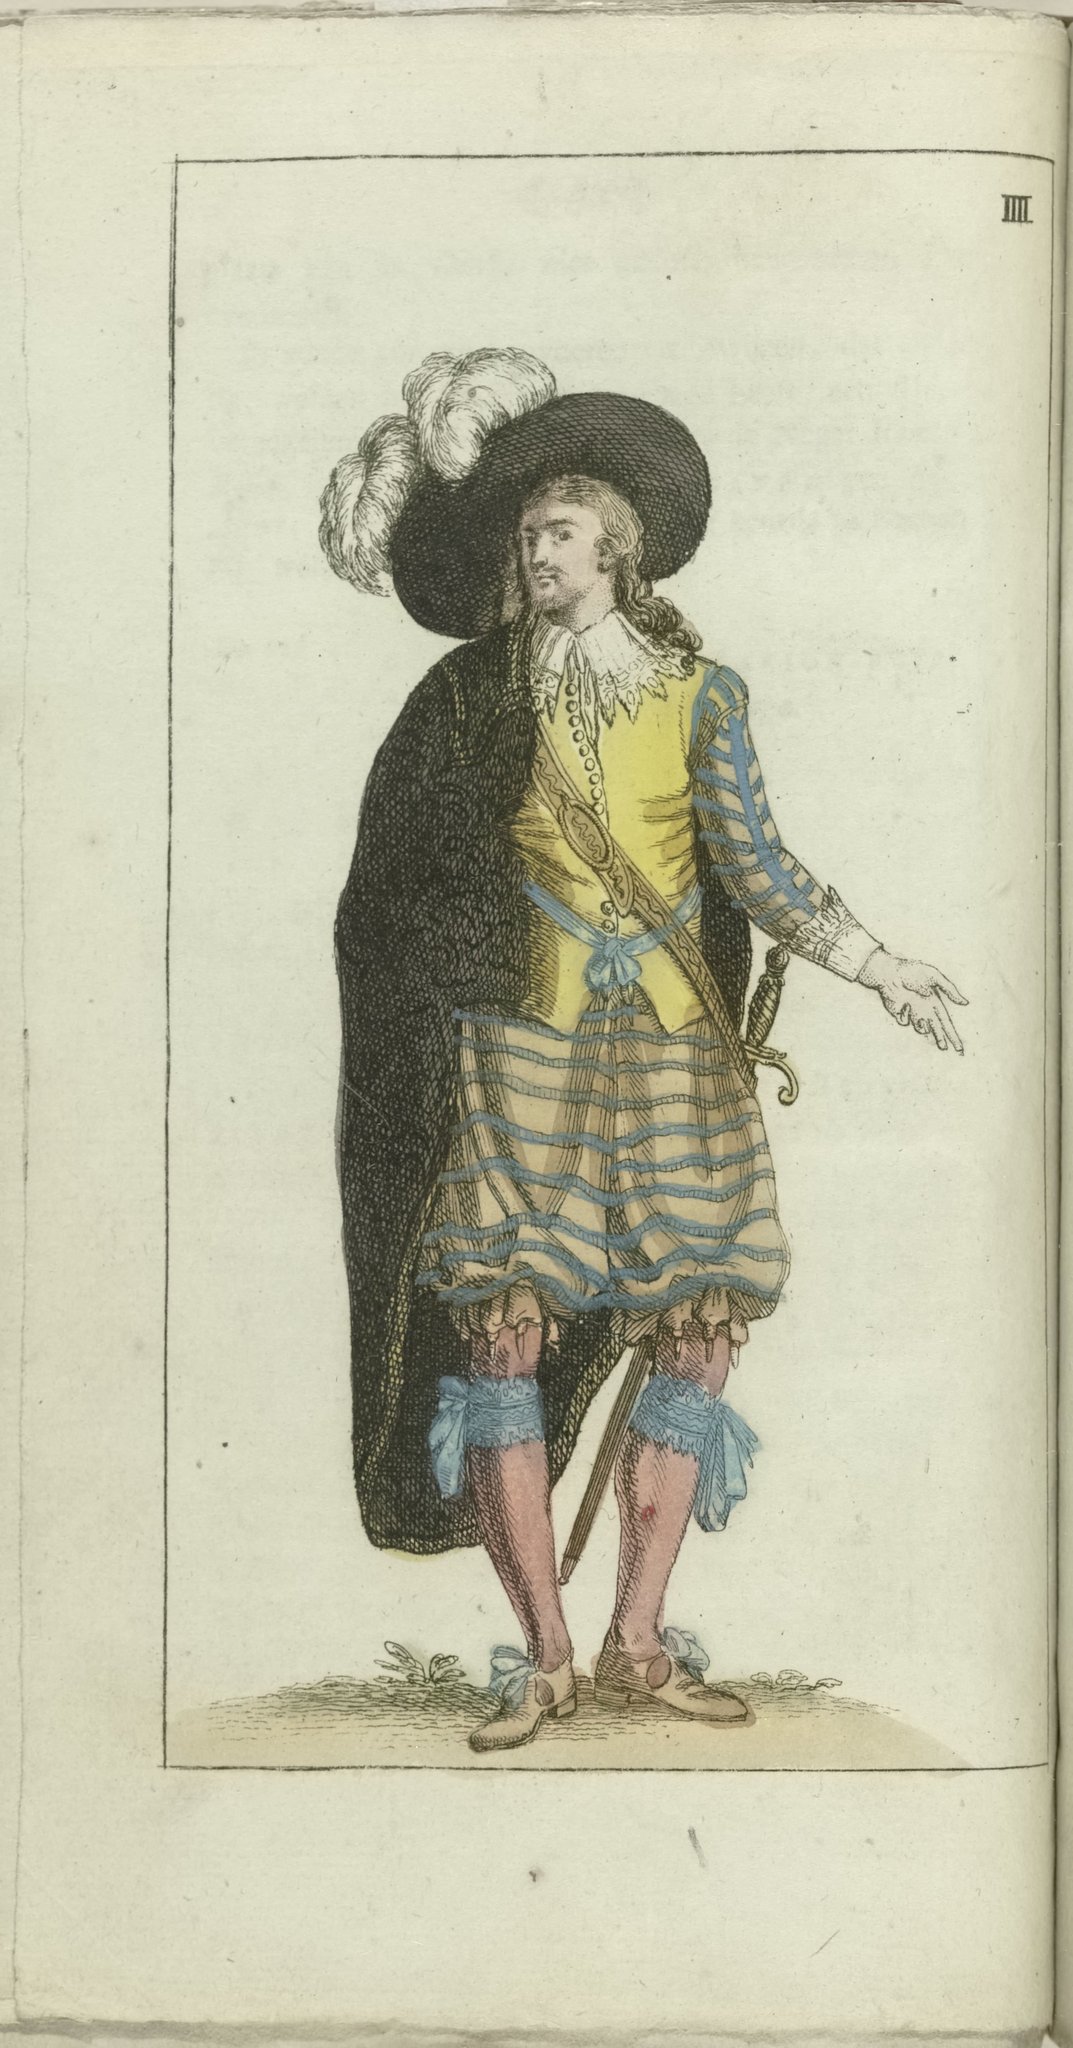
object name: fashion print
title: Kabinet van mode en smaak 1791, pl. IIII: Een Petit maitre van de vroegste helft van 1600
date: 1791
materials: paper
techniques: etching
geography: haarlem